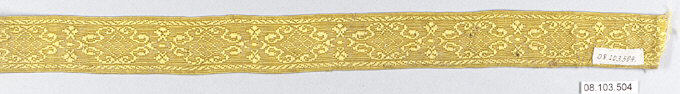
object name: galloon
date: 1701-1800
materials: cotton, silk